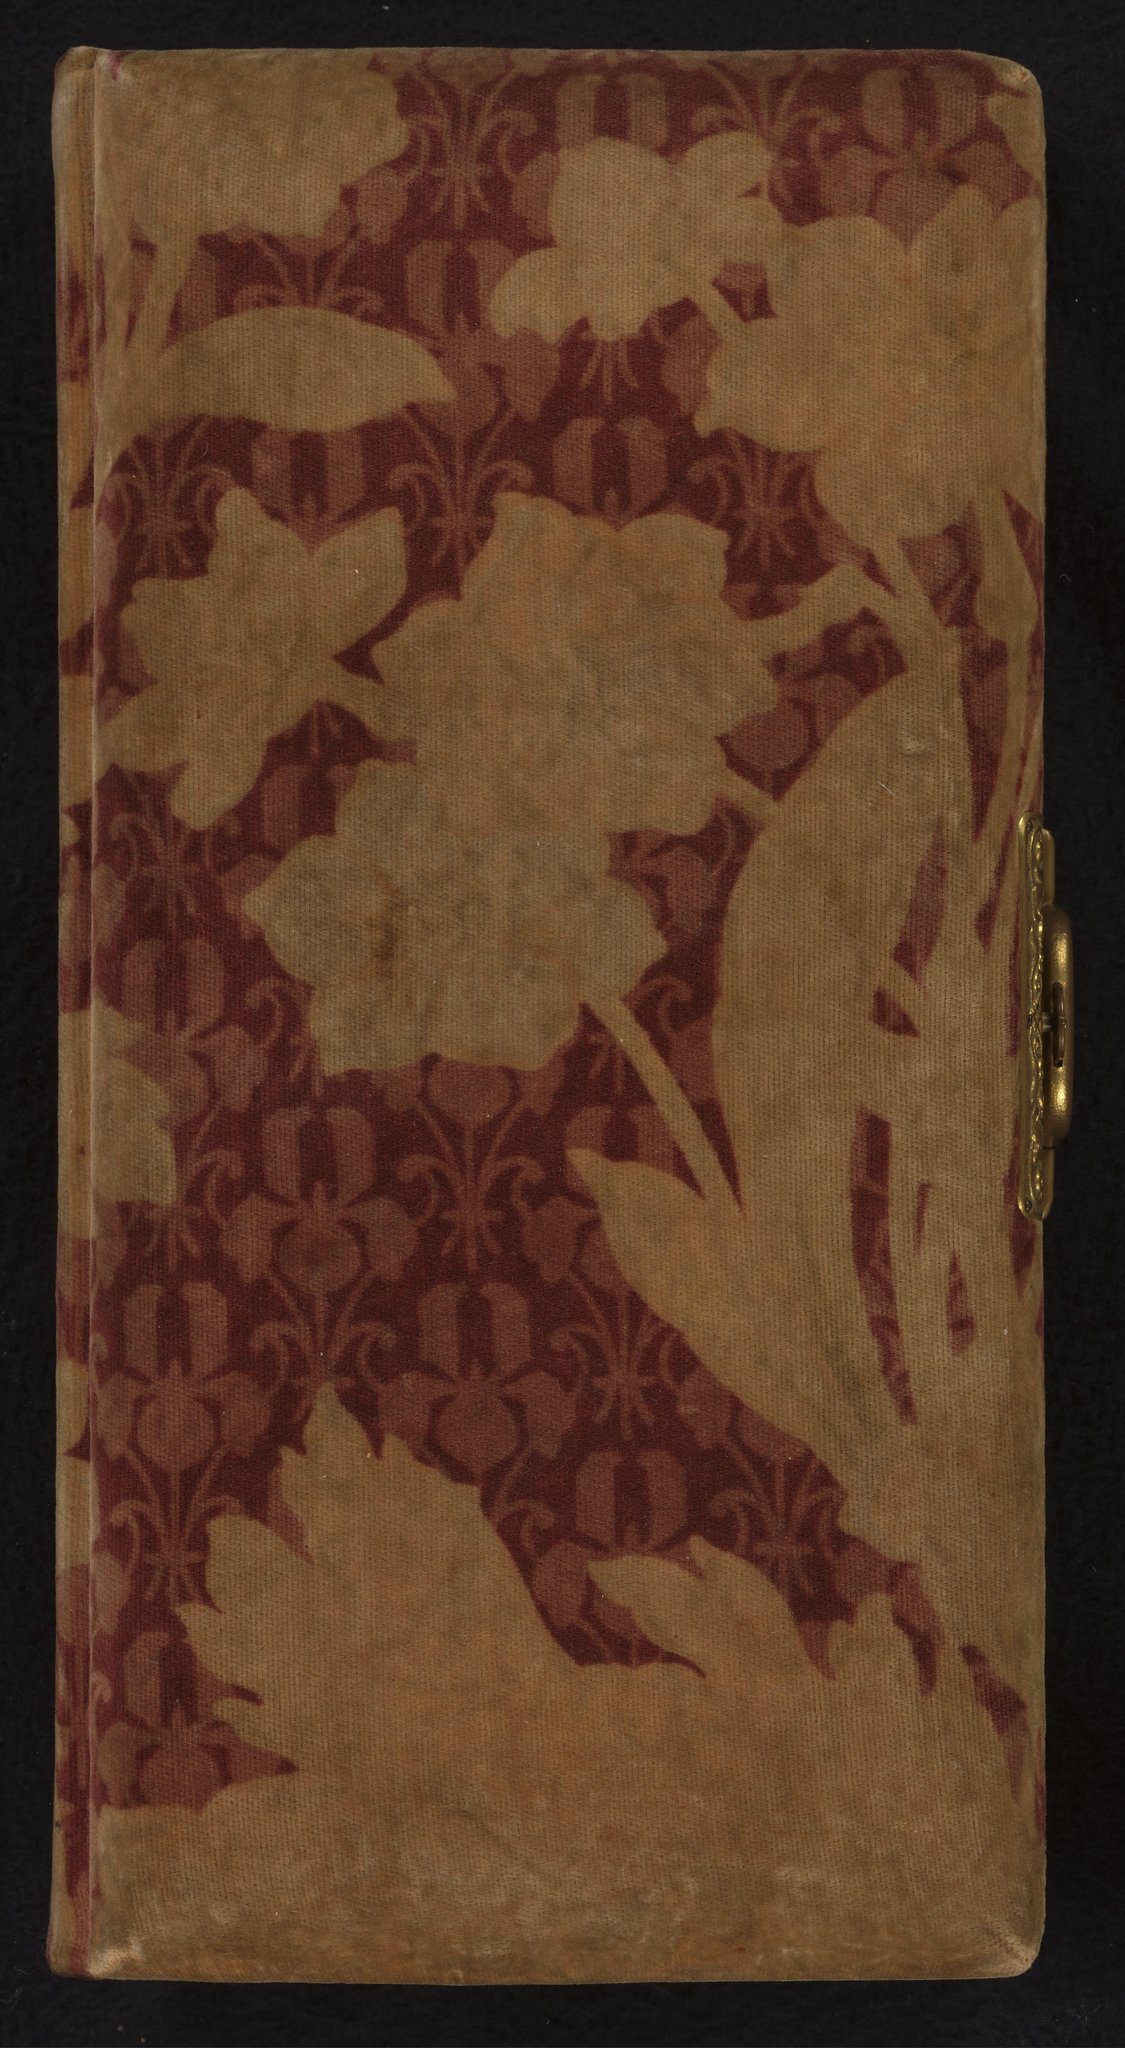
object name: slip in album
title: Fotoalbum met 50 foto's, Nederlands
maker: Anonymous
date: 1860-1920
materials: cardboard, metal, paper, photographic support, plastic, textile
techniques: albumen print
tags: historical persons - bb - woman, boy (child between toddler and youth), historical persons, girl (child between toddler and youth)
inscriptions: collector's mark: ‘Dienst Verspreide Rijkscollekties/ Inv.nr: A974’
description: Fotoalbum met 50 foto's op 26 pagina's. Het album bevat portretten, onder andere vervaardigd door Hendrik Jonker, Max Büttinghausen en Carl Wilhelm Bauer, enkele foto's zijn anoniem. Daarnaast bevatten sommige foto's het opschrift "AV" of "A. Voget". Vermoedelijk zijn alle foto's vervaardigd in Nederland en elke pagina bevat zowel een carte-de-visite als een kabinetfoto. Op de binnenzijde van het voorplat zitten twee foto's geplakt.